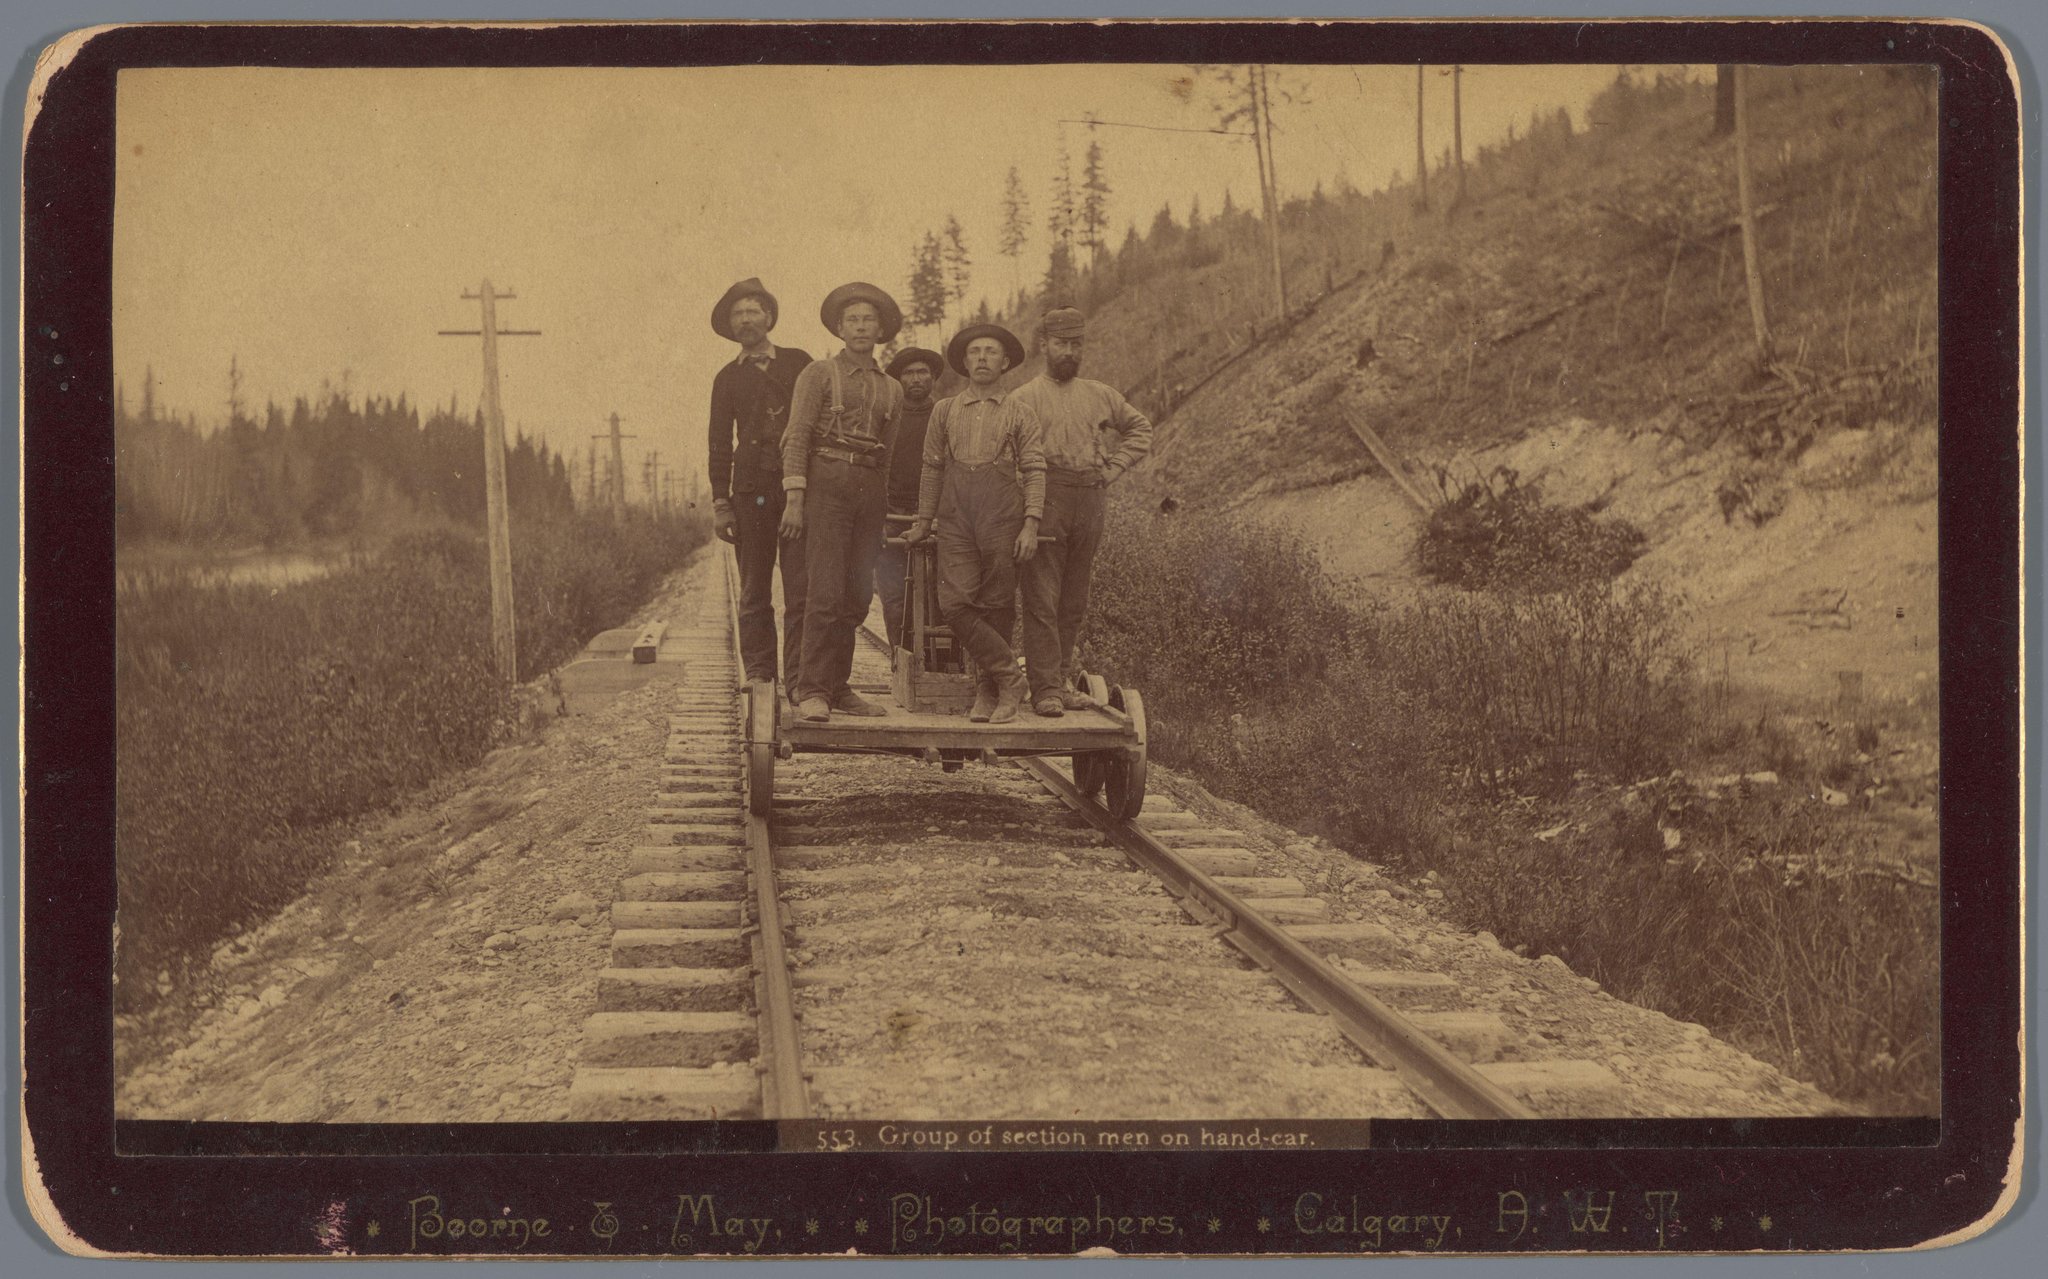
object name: cabinet photograph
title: Spoorwegarbeiders poseren op handcar op het land van M. Hanbury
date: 1890-1900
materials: photographic support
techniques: albumen print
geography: calgary